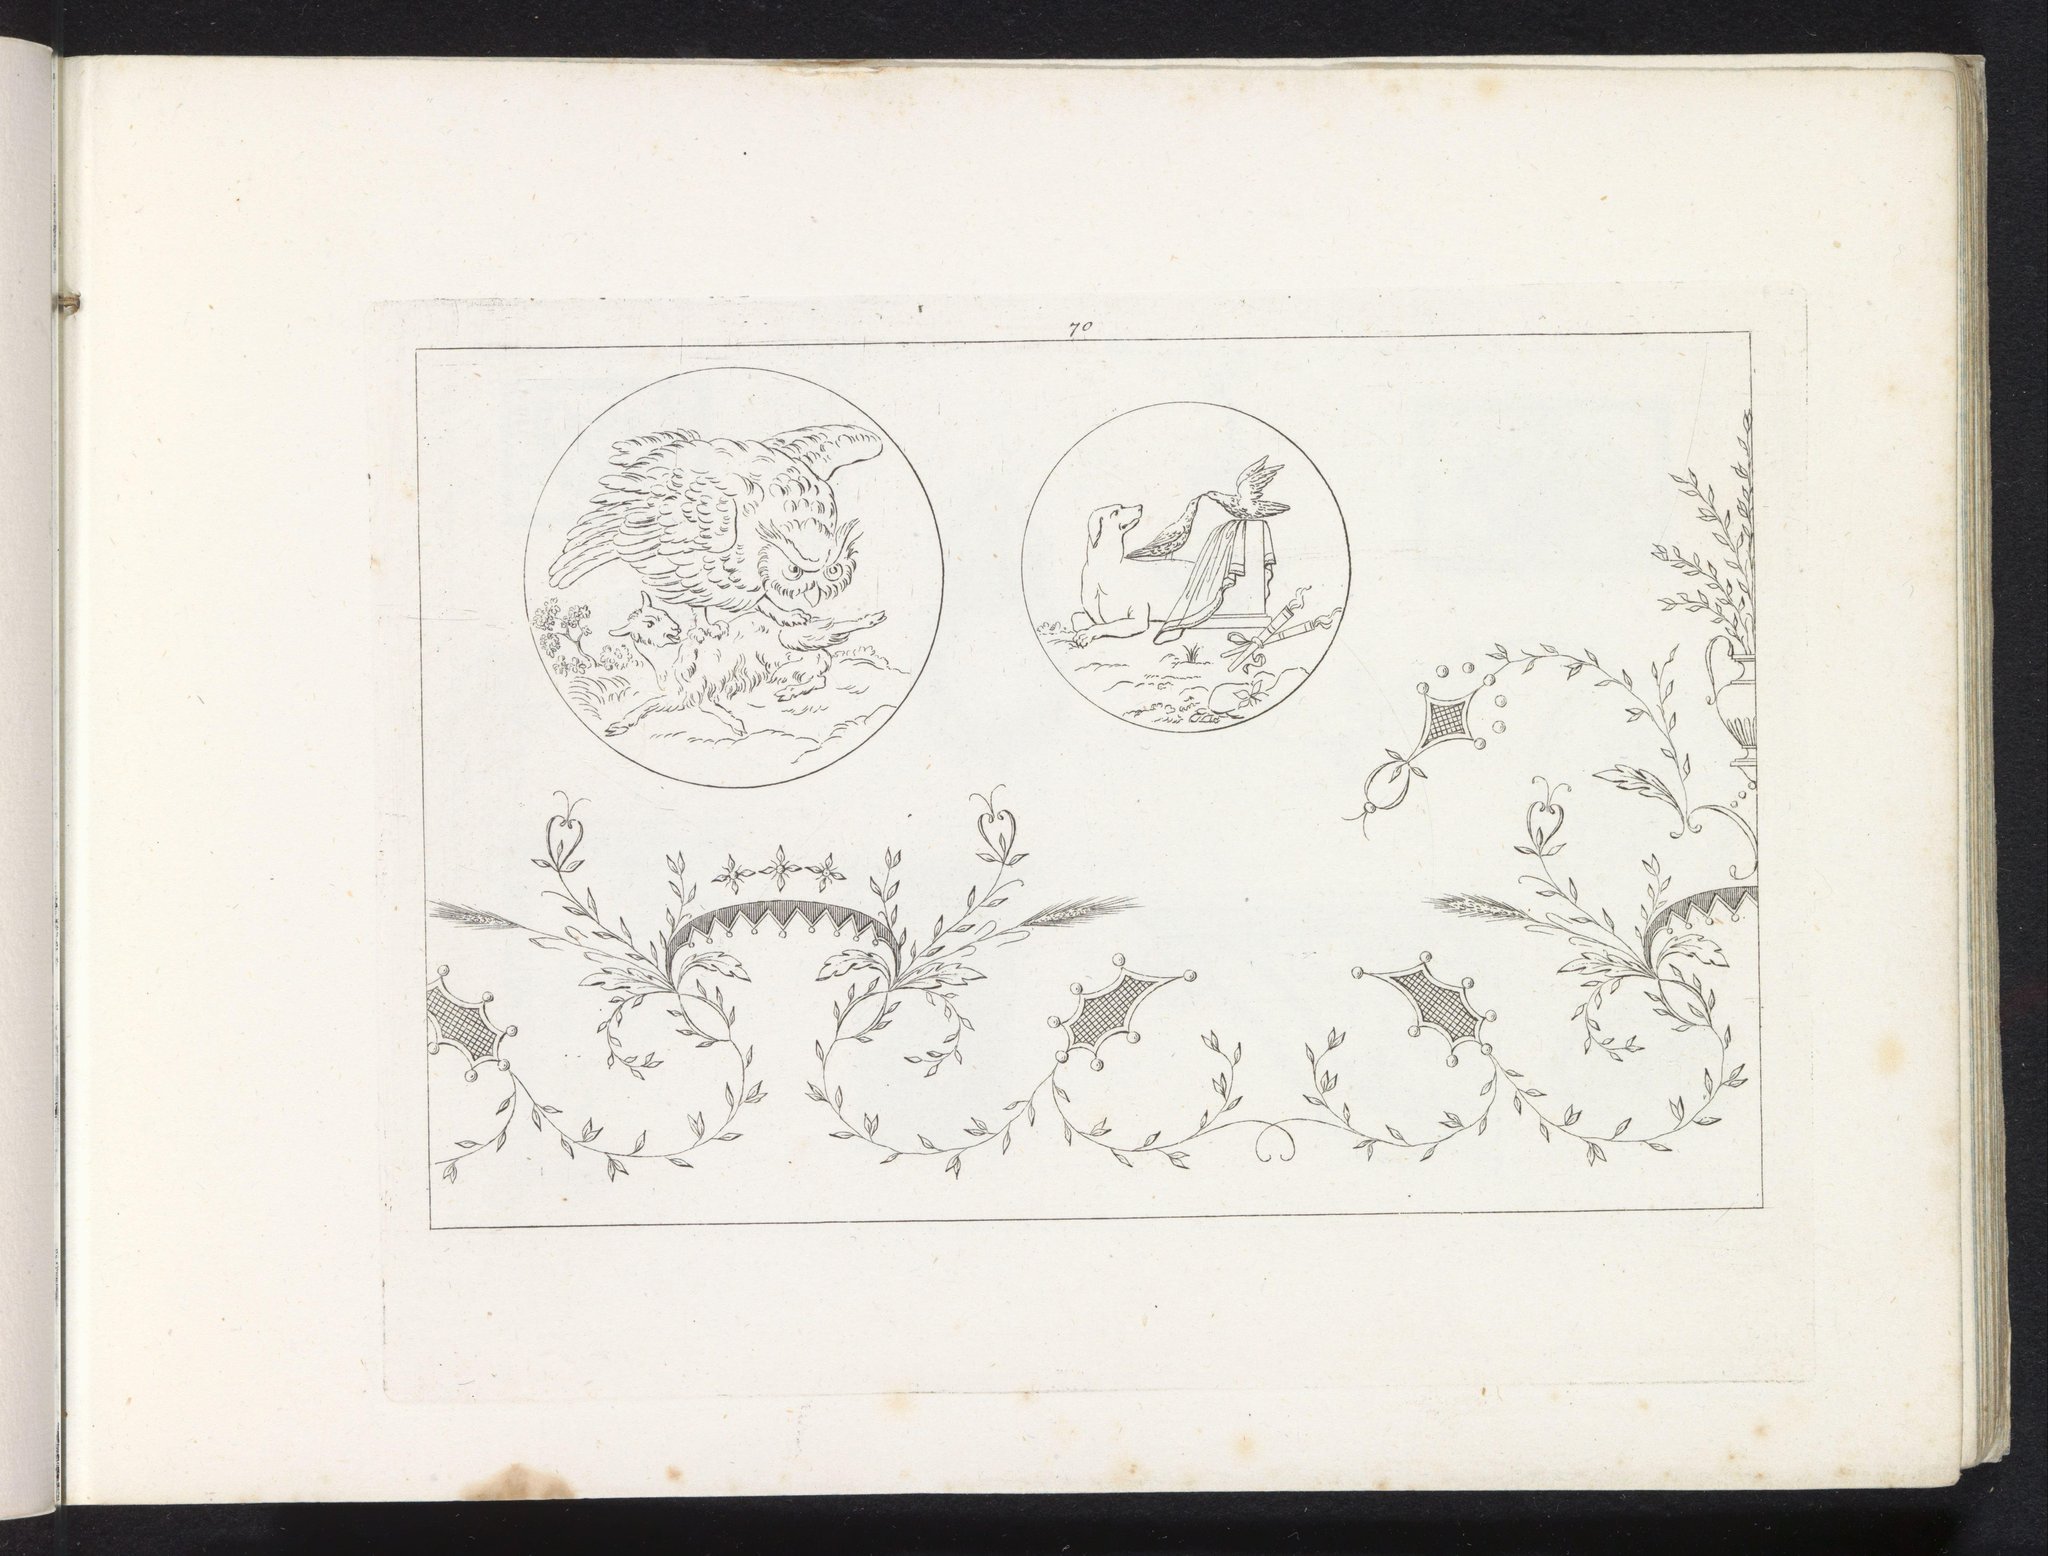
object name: album leaf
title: Invenzioni diverse di mobili ed utensili sacri e profani per usi comuni della vita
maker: pietro ruga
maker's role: print maker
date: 1817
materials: paper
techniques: etching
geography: italy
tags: ornaments ~ art, ornament ~ medallion, owls, dog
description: Prent maakt deel uit van een reeks van 100 prenten (+ titelprent) met ontwerpen voor religieuze en profane voorwerpen.